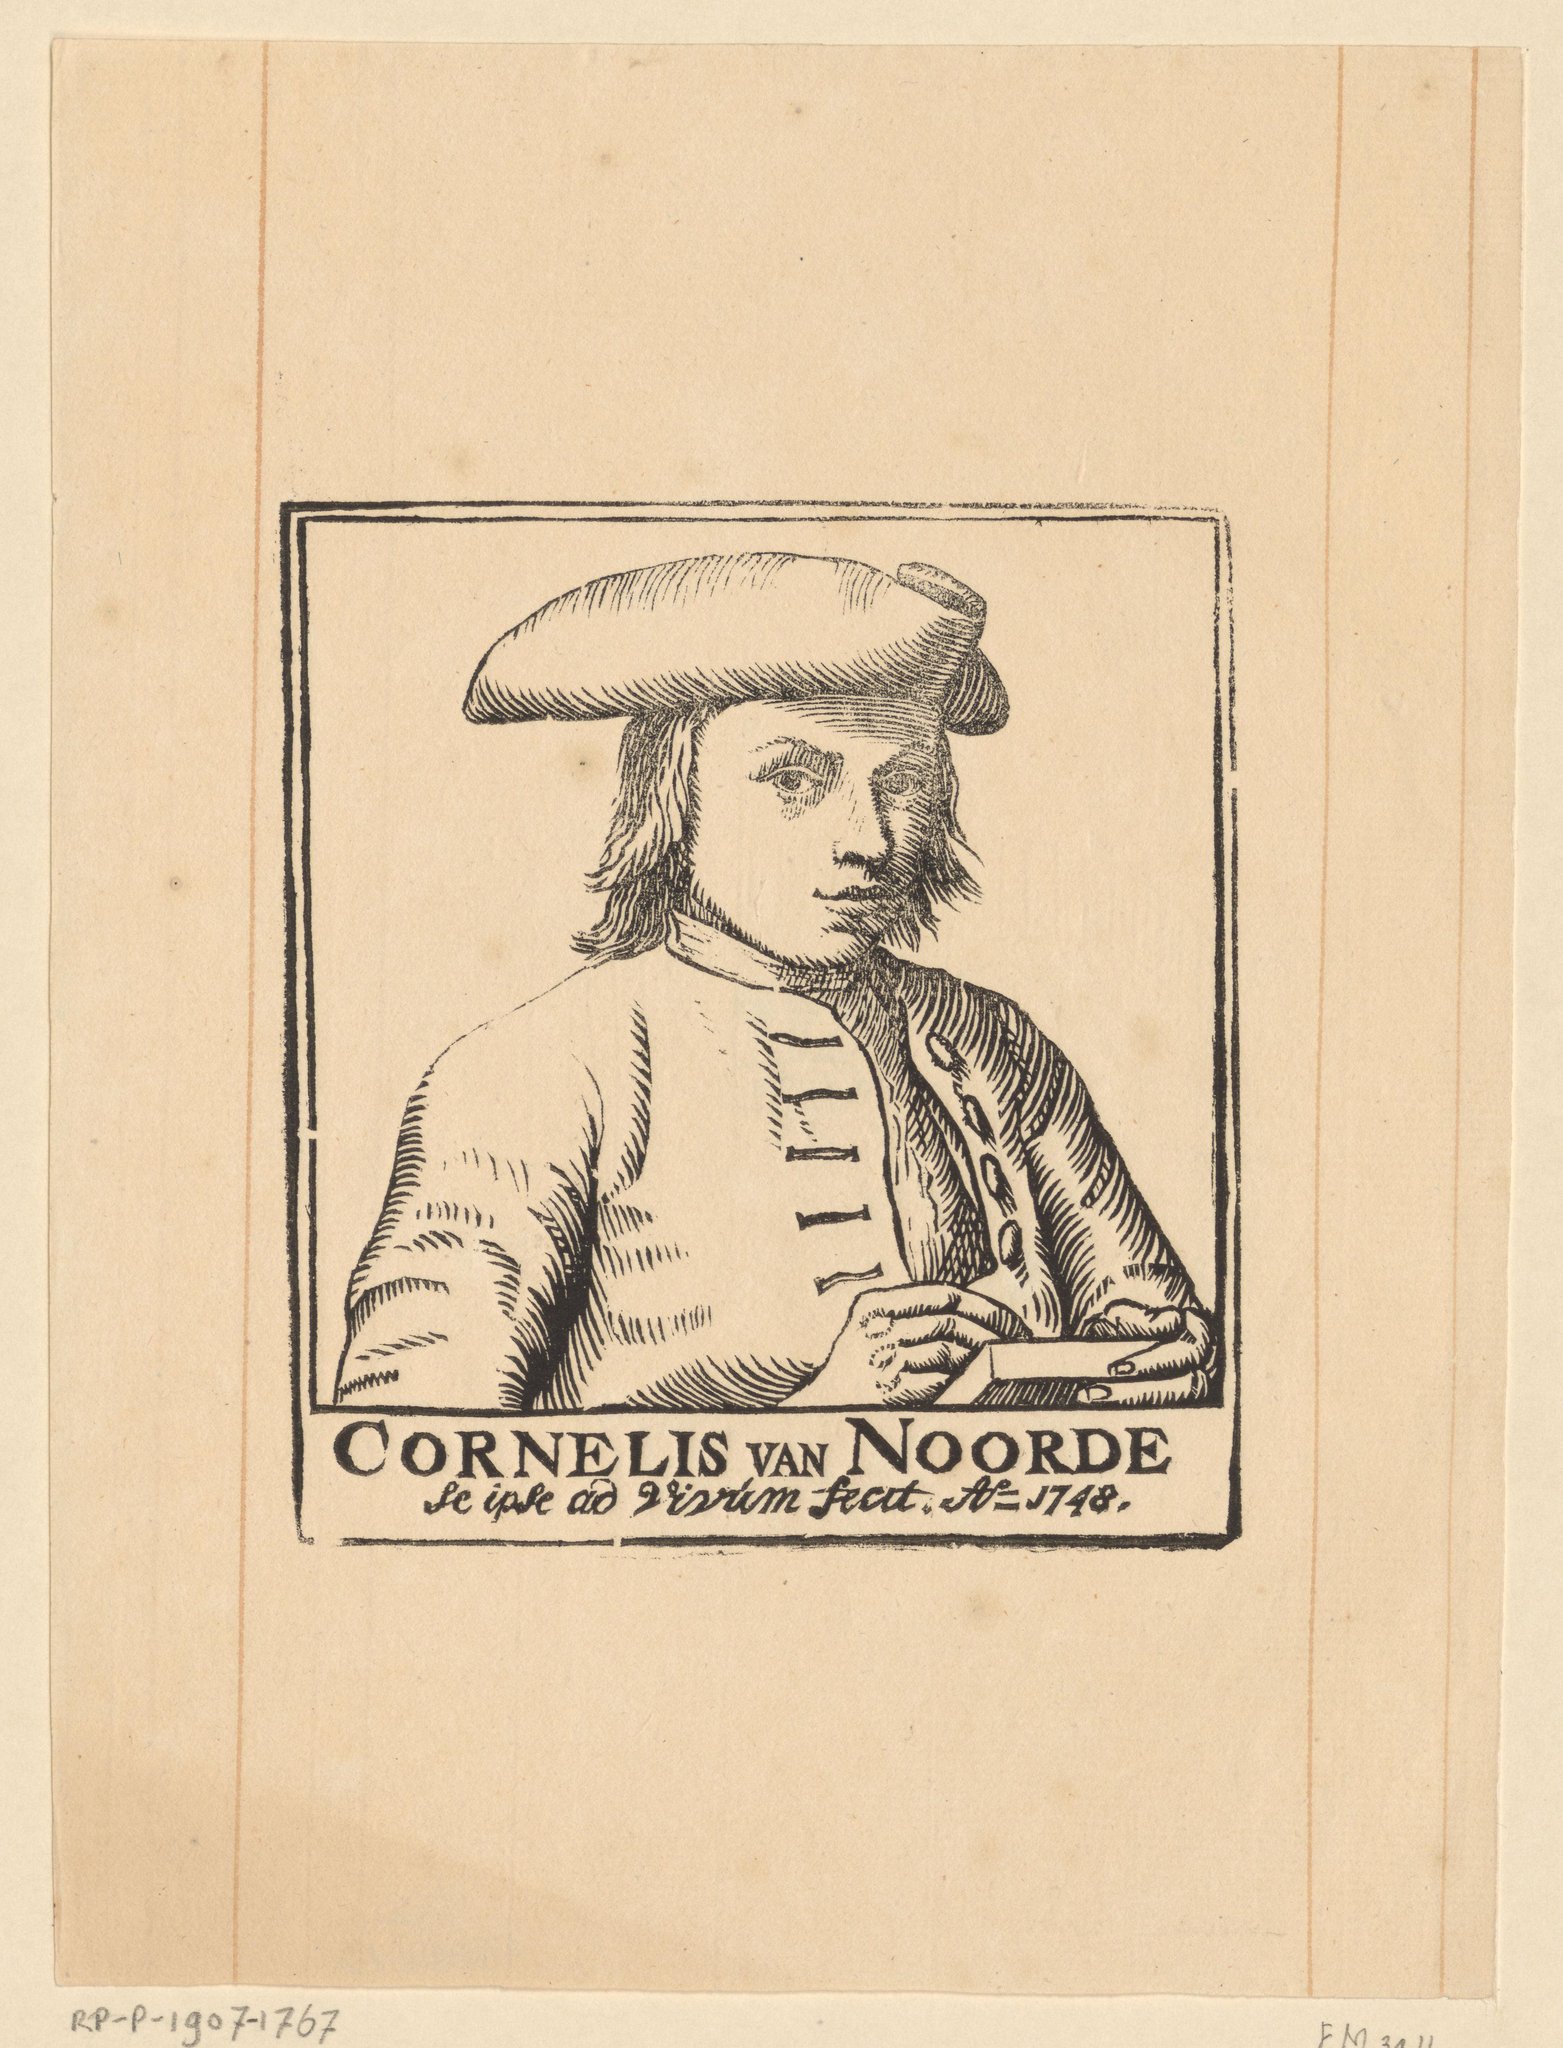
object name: print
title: Zelfportret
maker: cornelis van noorde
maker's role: draughtsman, print maker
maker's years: 1731-1795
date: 1748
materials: paper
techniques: woodcut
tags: draughtsman, cornelis van noorde, historical persons, graphic artist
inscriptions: collector's mark: Lugt 2228